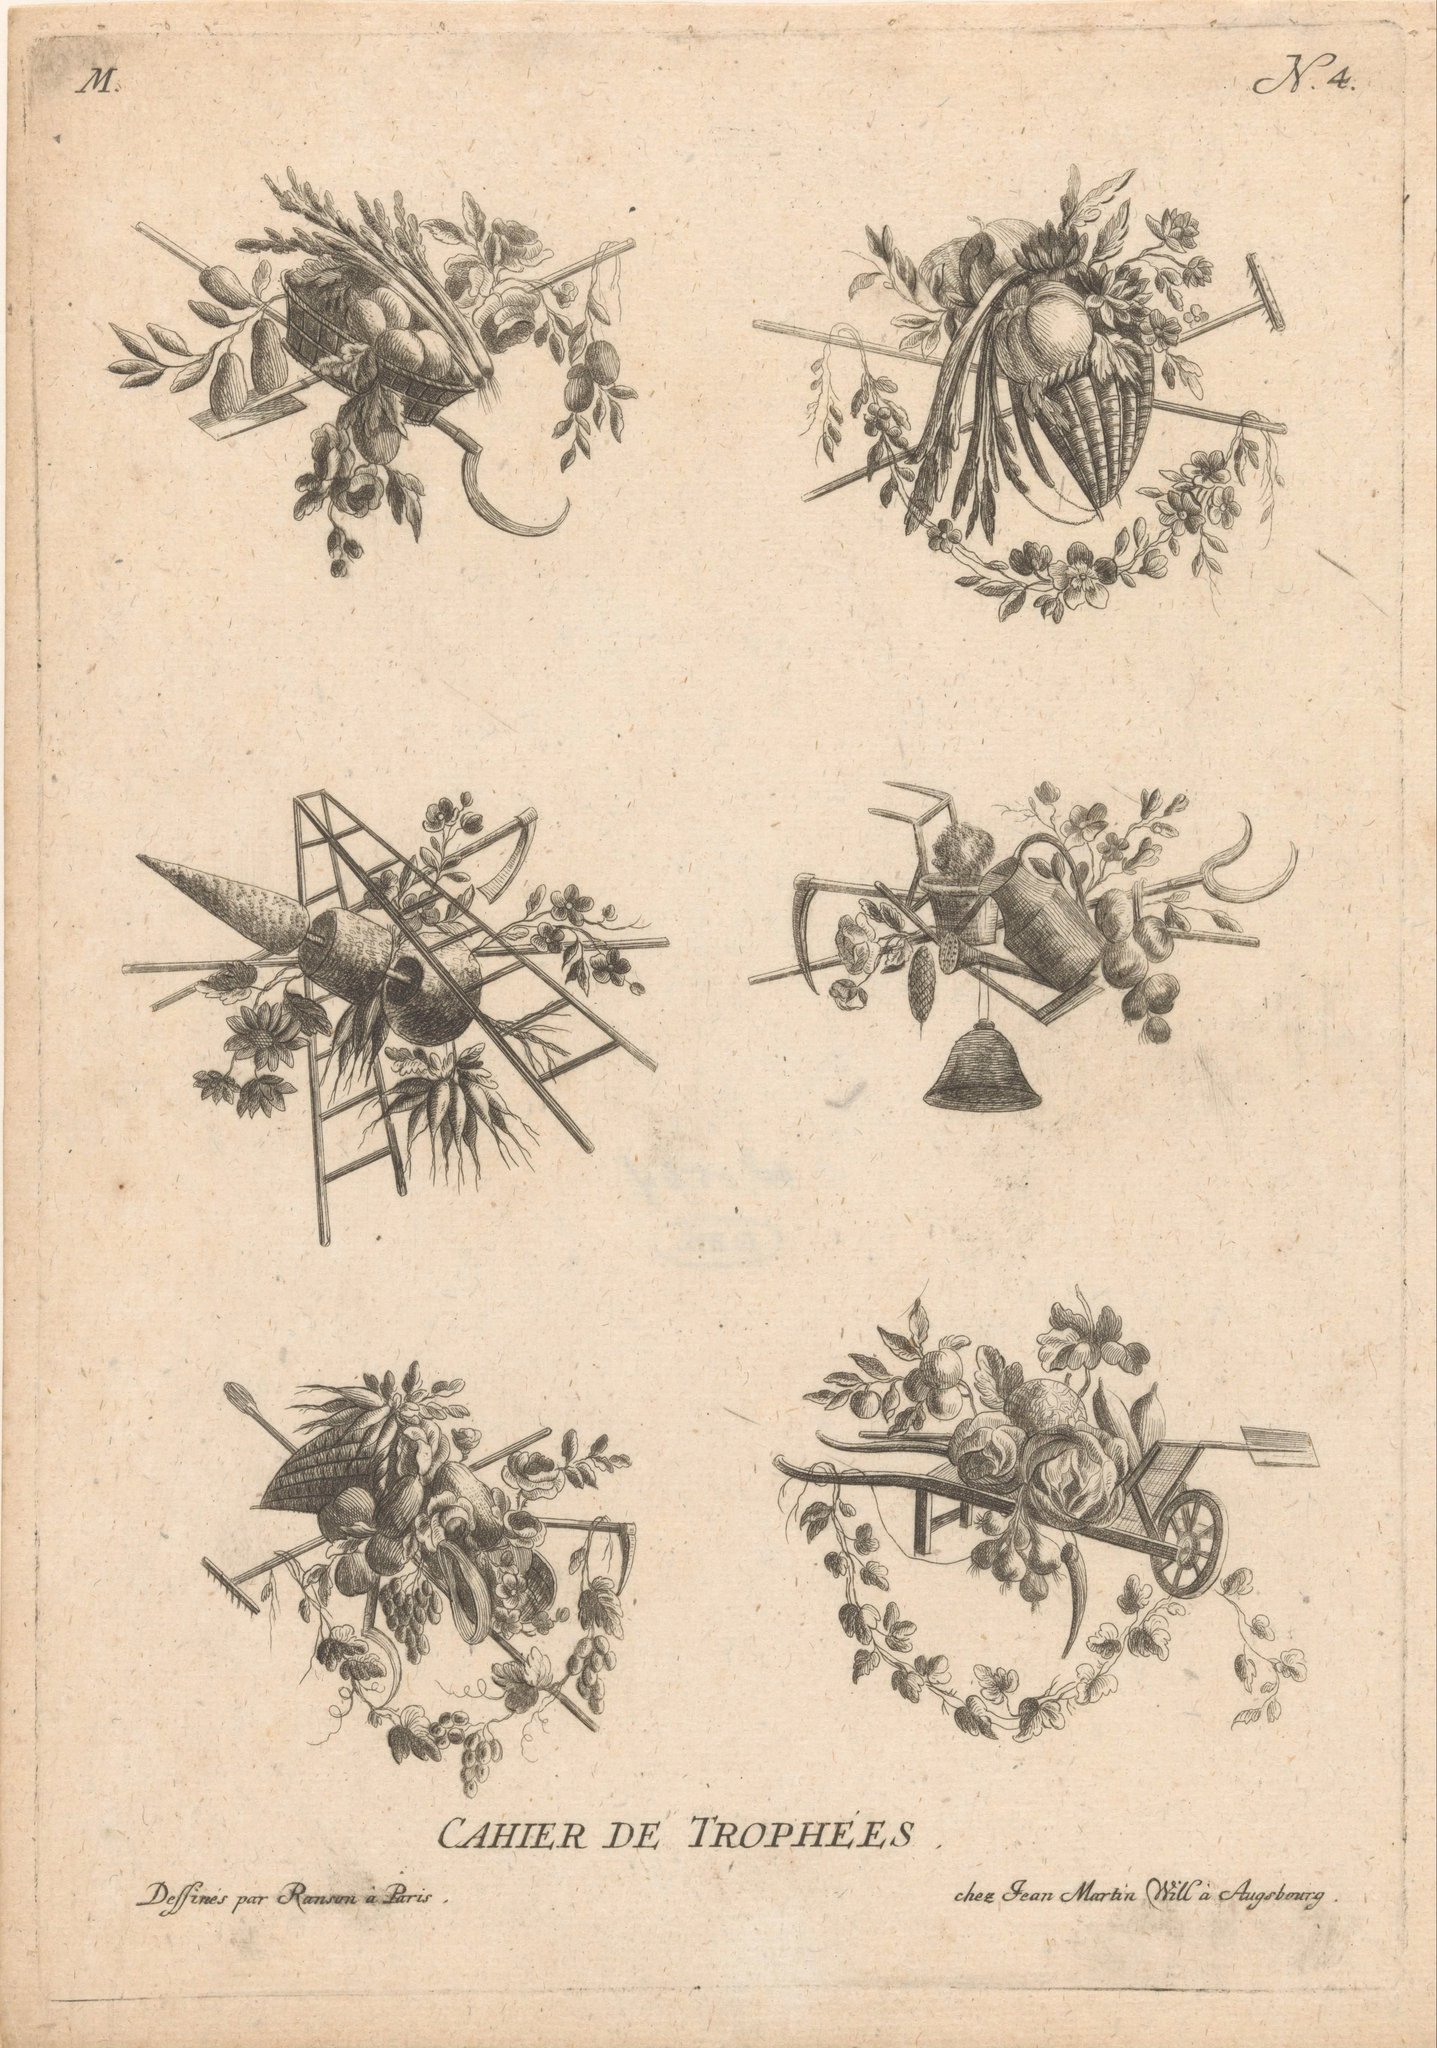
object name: print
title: Trofeeën met attributen behorend bij tuinieren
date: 1772-1806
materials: paper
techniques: etching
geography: paris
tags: trophy, i.e.: decorative arrangement of symbolic or typical objects ~ ornament, gardening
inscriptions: collector's mark: Lugt 2228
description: Zes trofeeën met attributen behorend bij tuinieren zoals bloemen, een sikkel, een schep, een hark, een trap, een gieter en een kruiwagen.